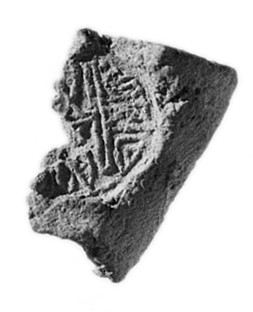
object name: sealing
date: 1981-1640 BCE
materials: mud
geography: egypt